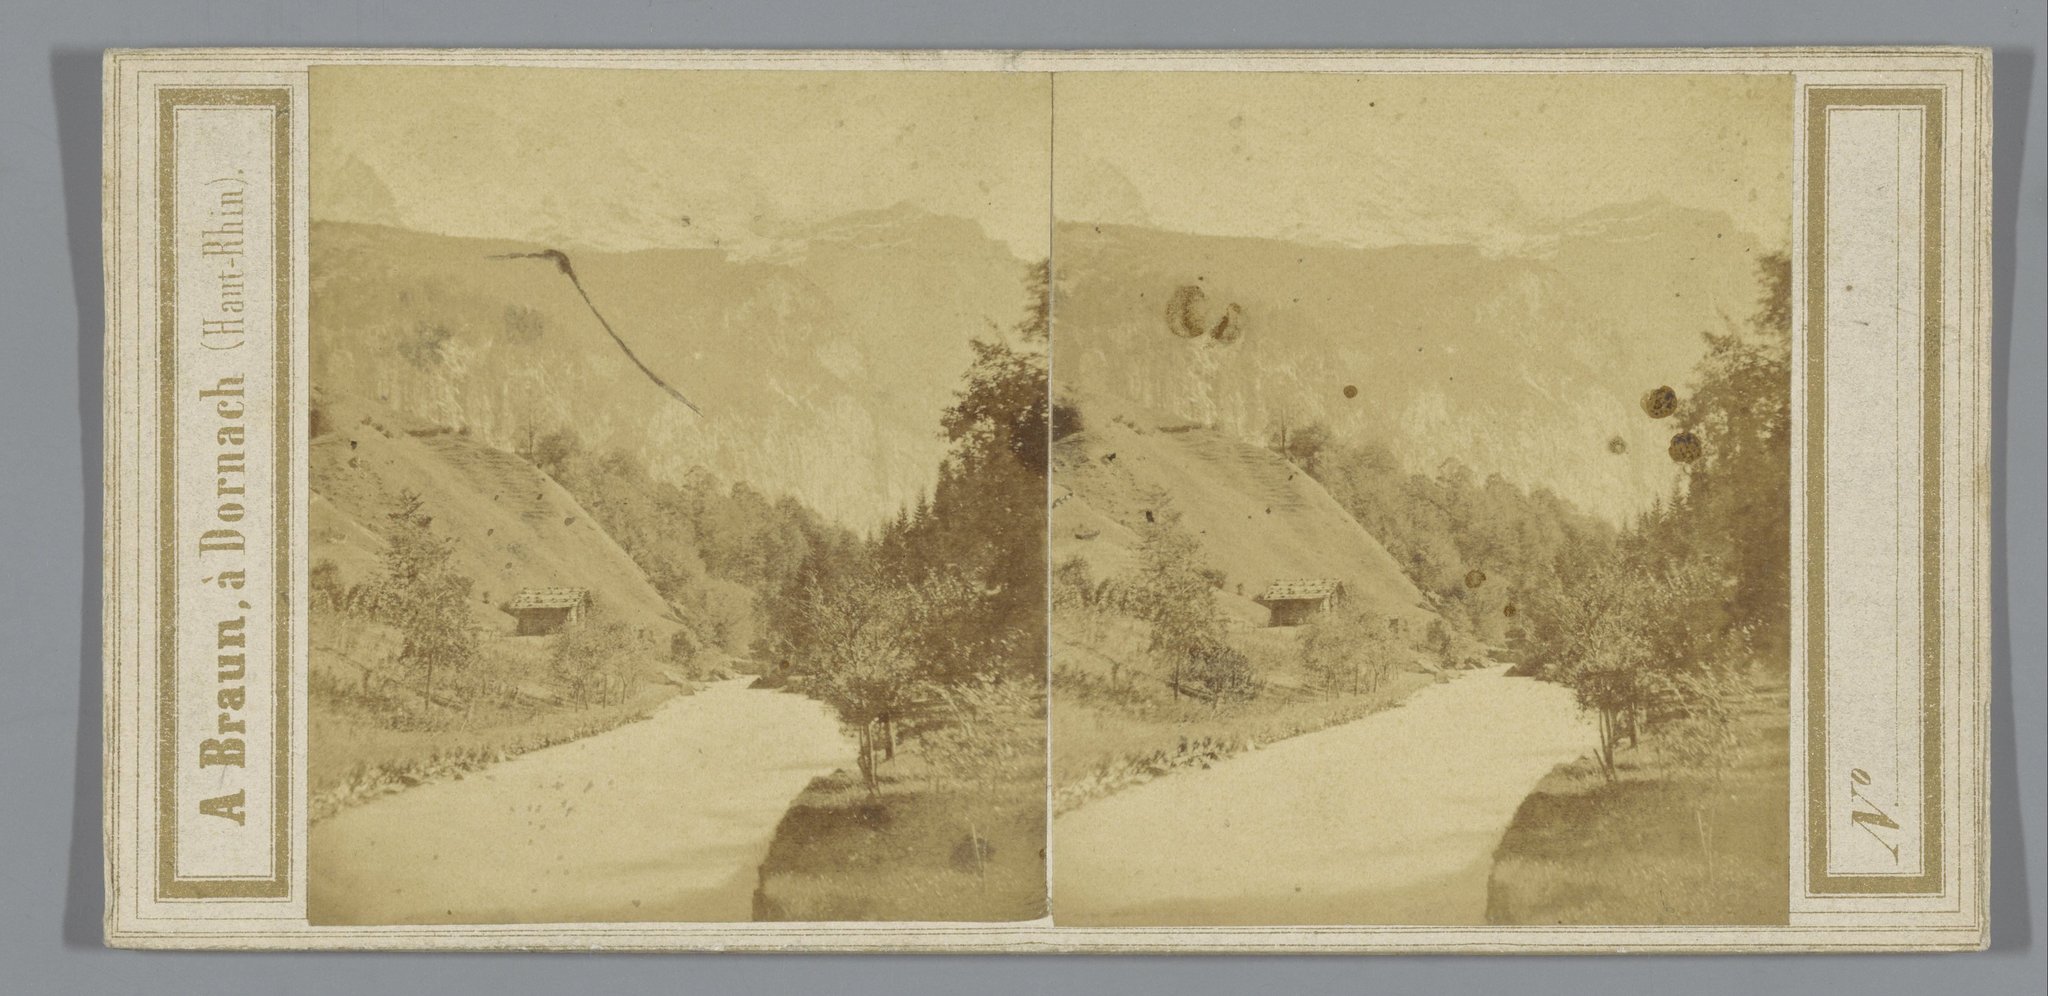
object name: stereograph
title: Berglandschap met landweg, vermoedelijk in Zwitserland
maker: Anonymous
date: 1860-1866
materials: cardboard, paper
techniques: albumen print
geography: dornach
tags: road, path, mountain-range, snow peaks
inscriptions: number: ‘6’